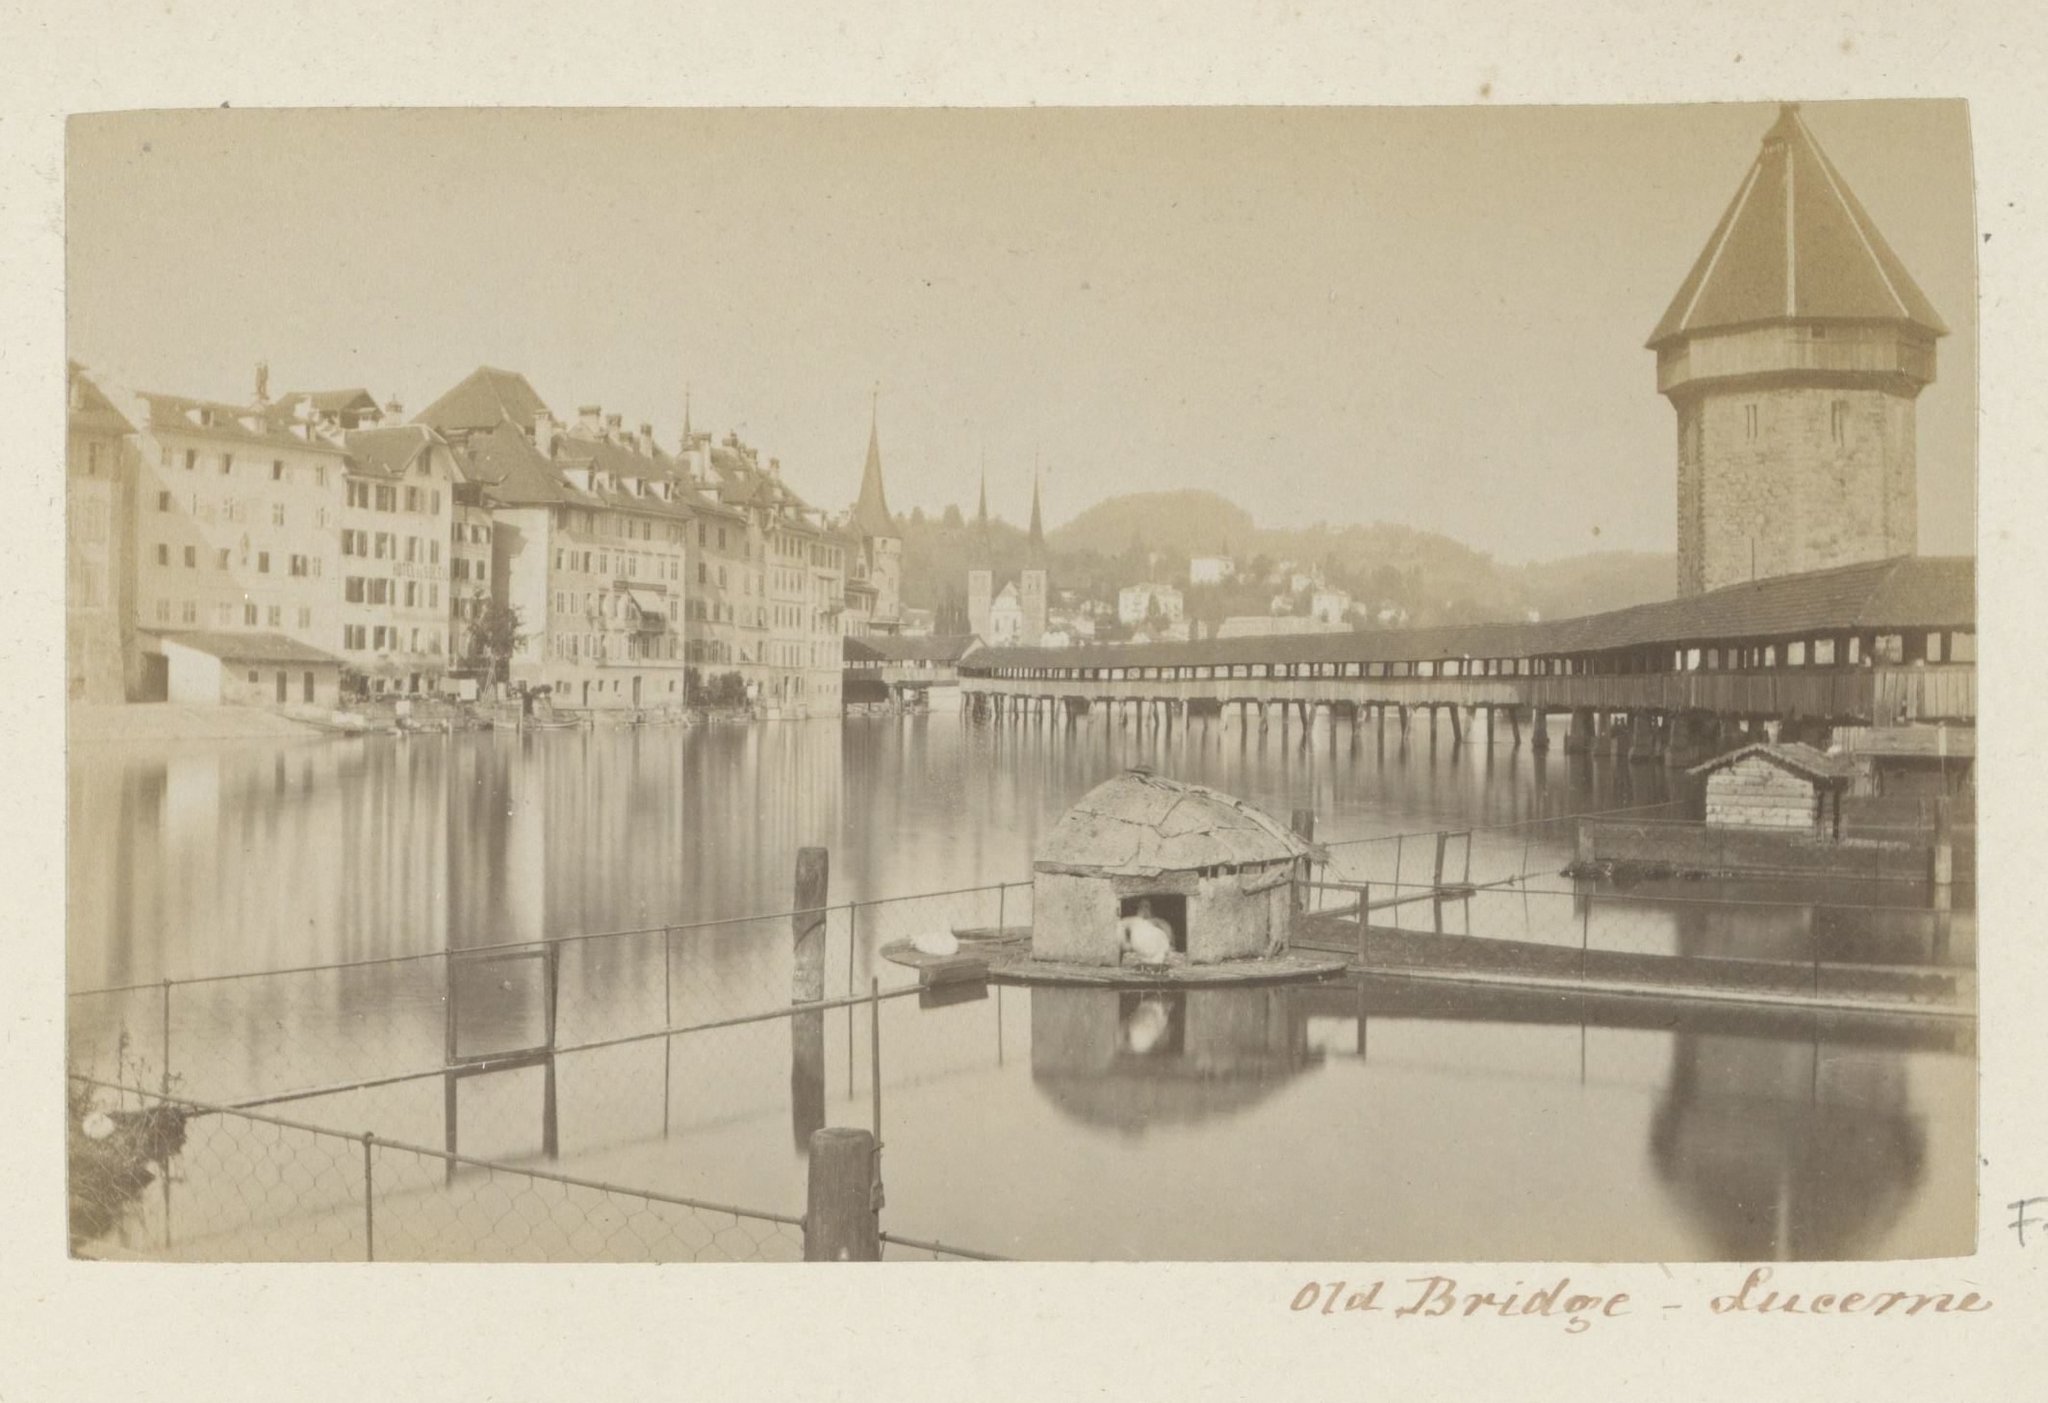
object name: photograph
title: Kapelbrug en watertoren in Luzern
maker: Anonymous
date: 1860-1890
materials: paper, photographic support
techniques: albumen print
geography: lucerne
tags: water tower, bridge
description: Onderdeel van Reisalbum met foto's van Zwitserland, Oostenrijk, Italië en Duitsland.